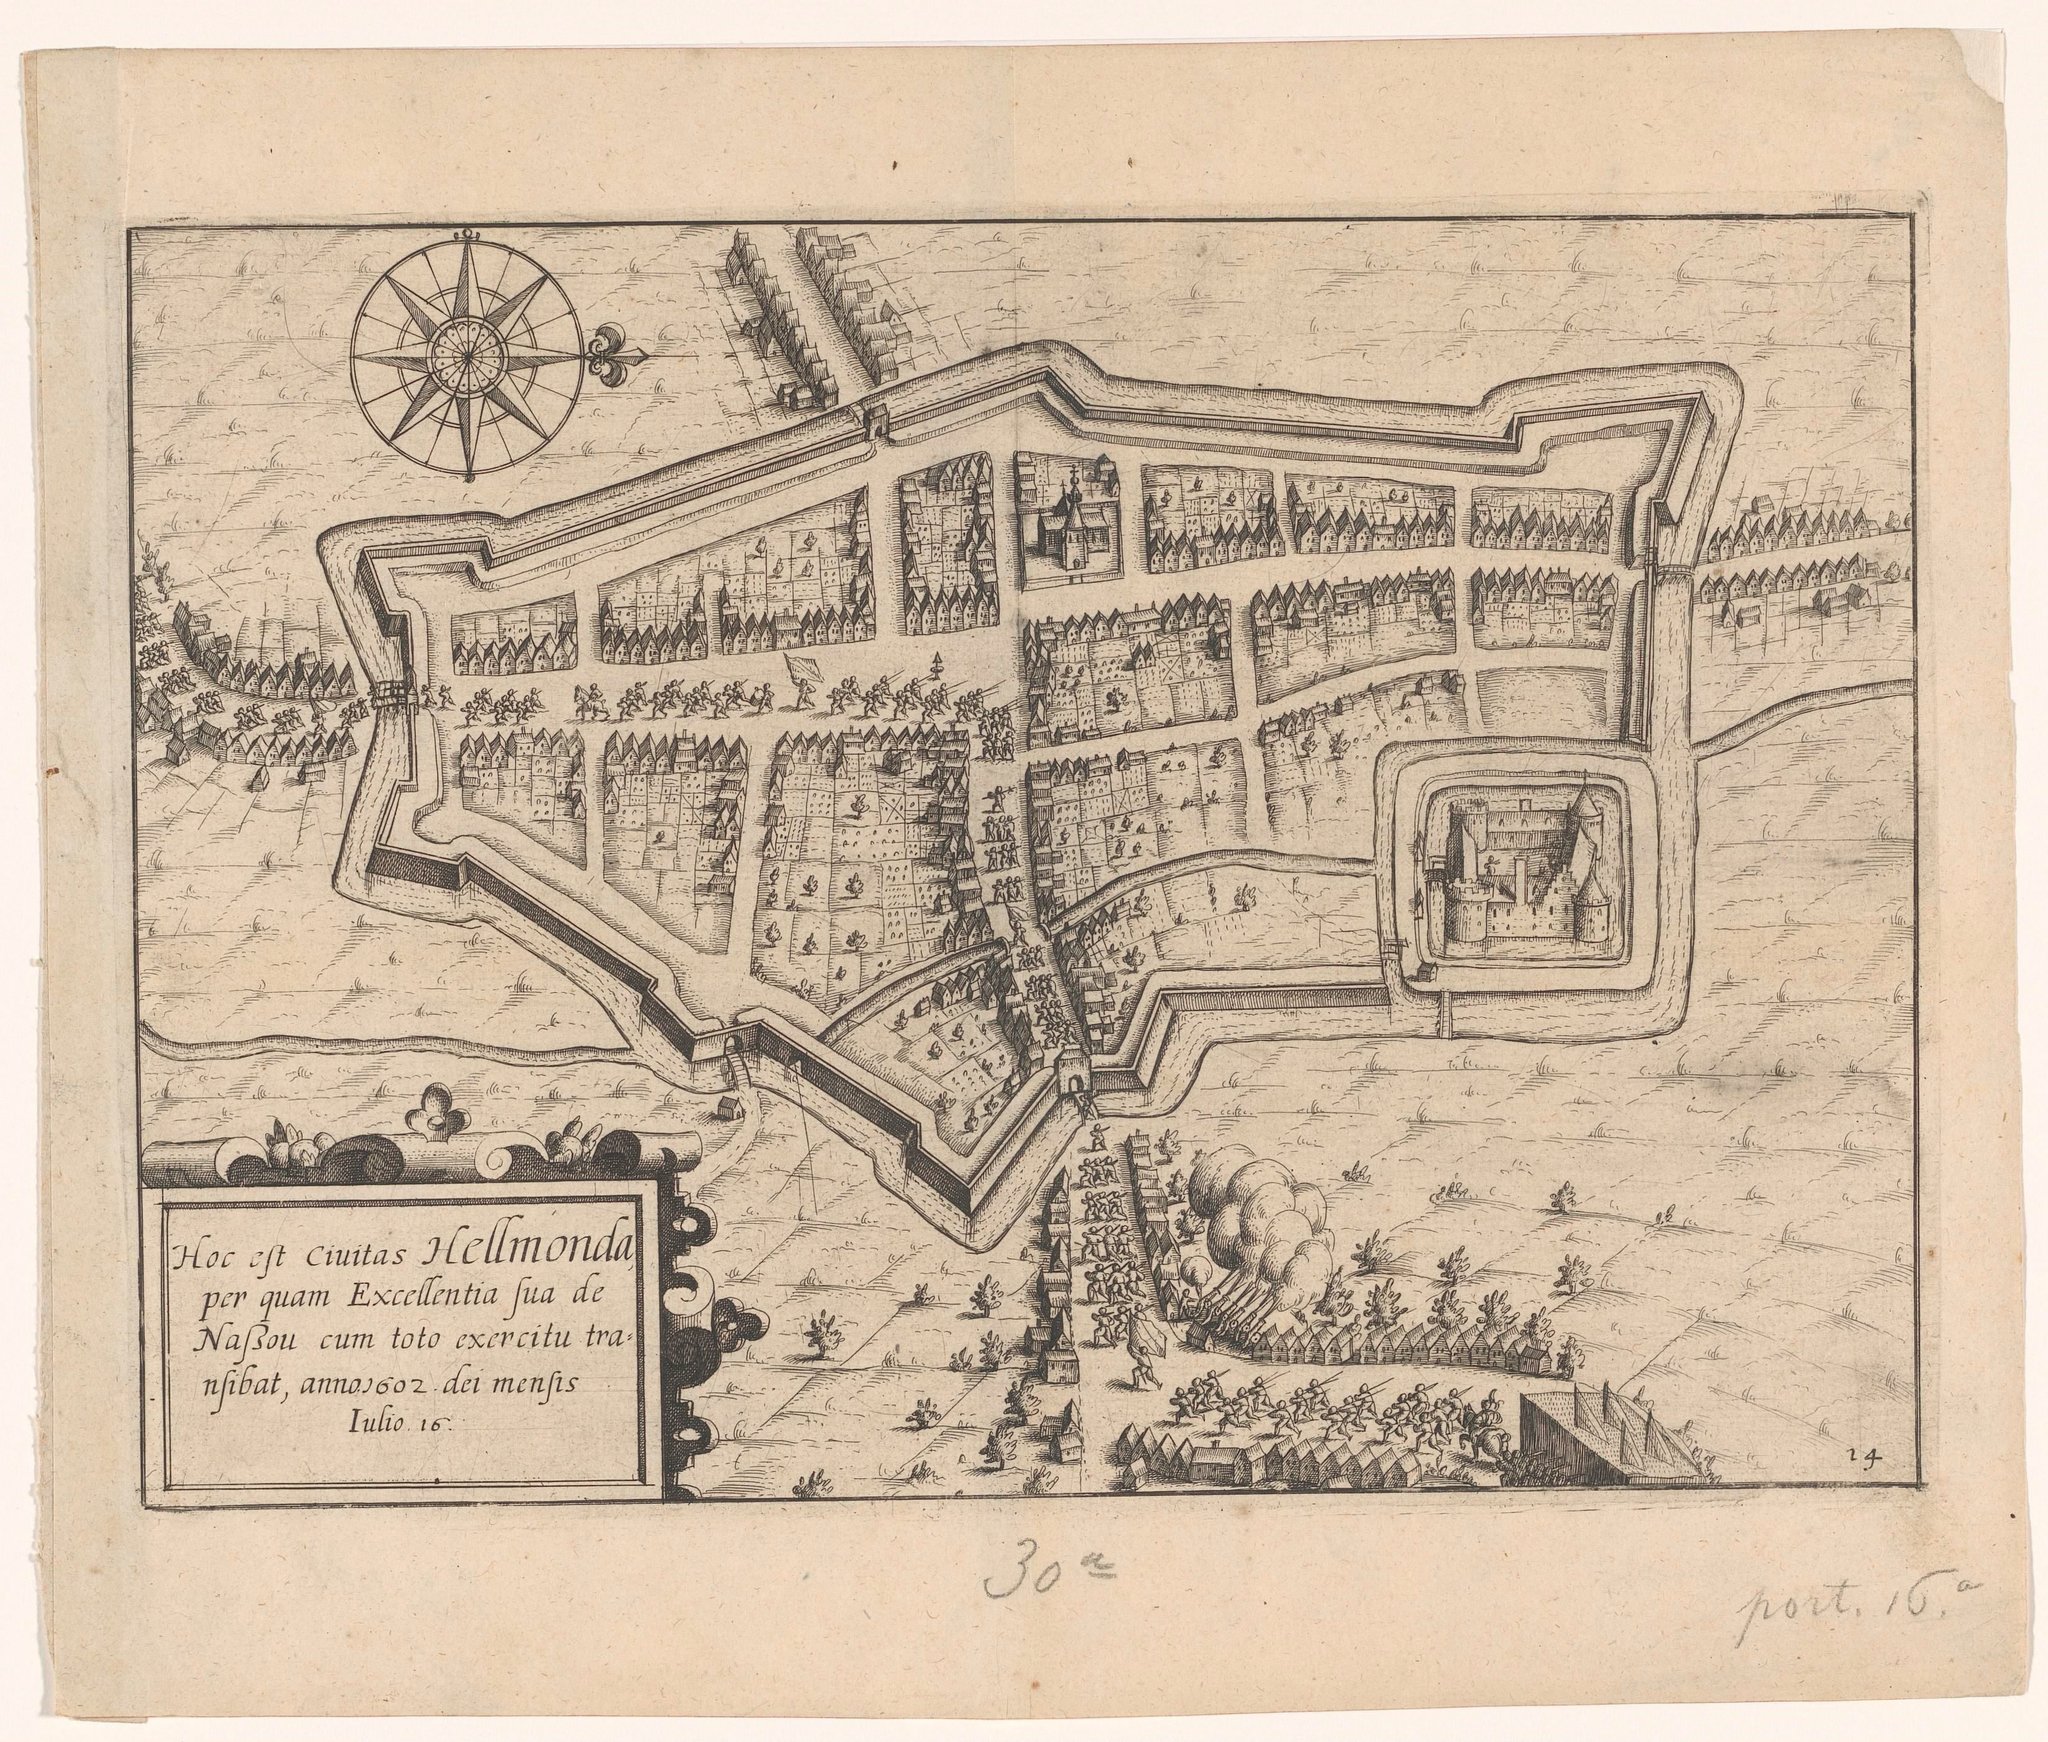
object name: print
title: Hoc est civitas Hellmonda per quam Excellentia sua de Nassou cum toto exercitu transibat, anno 1602. dei mensis Iulio 16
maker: lambert cornelisz.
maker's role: draughtsman, print maker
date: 1612-1648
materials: paper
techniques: engraving, etching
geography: amsterdam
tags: the hague, maurice (prince of orange), marching away (troops) (+ land forces), maps of cities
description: Deze staat van prent voor het eerst ook gebruikt in: Guicciardini, Lodovico. Beschryvinghe van alle de Neder-landen, anderssins ghenoemt Neder-Duytslandt (…). Amsterdam: Willem Janszoon Blaeu, 1612. Hierna is deze prent tot 1648 nog gebruikt in latere uitgaven van deze publicatie, uitgegeven door Blaeu en daarna door Janssonius. Uit welke uitgave het huidige exemplaar precies komt is niet na te gaan.